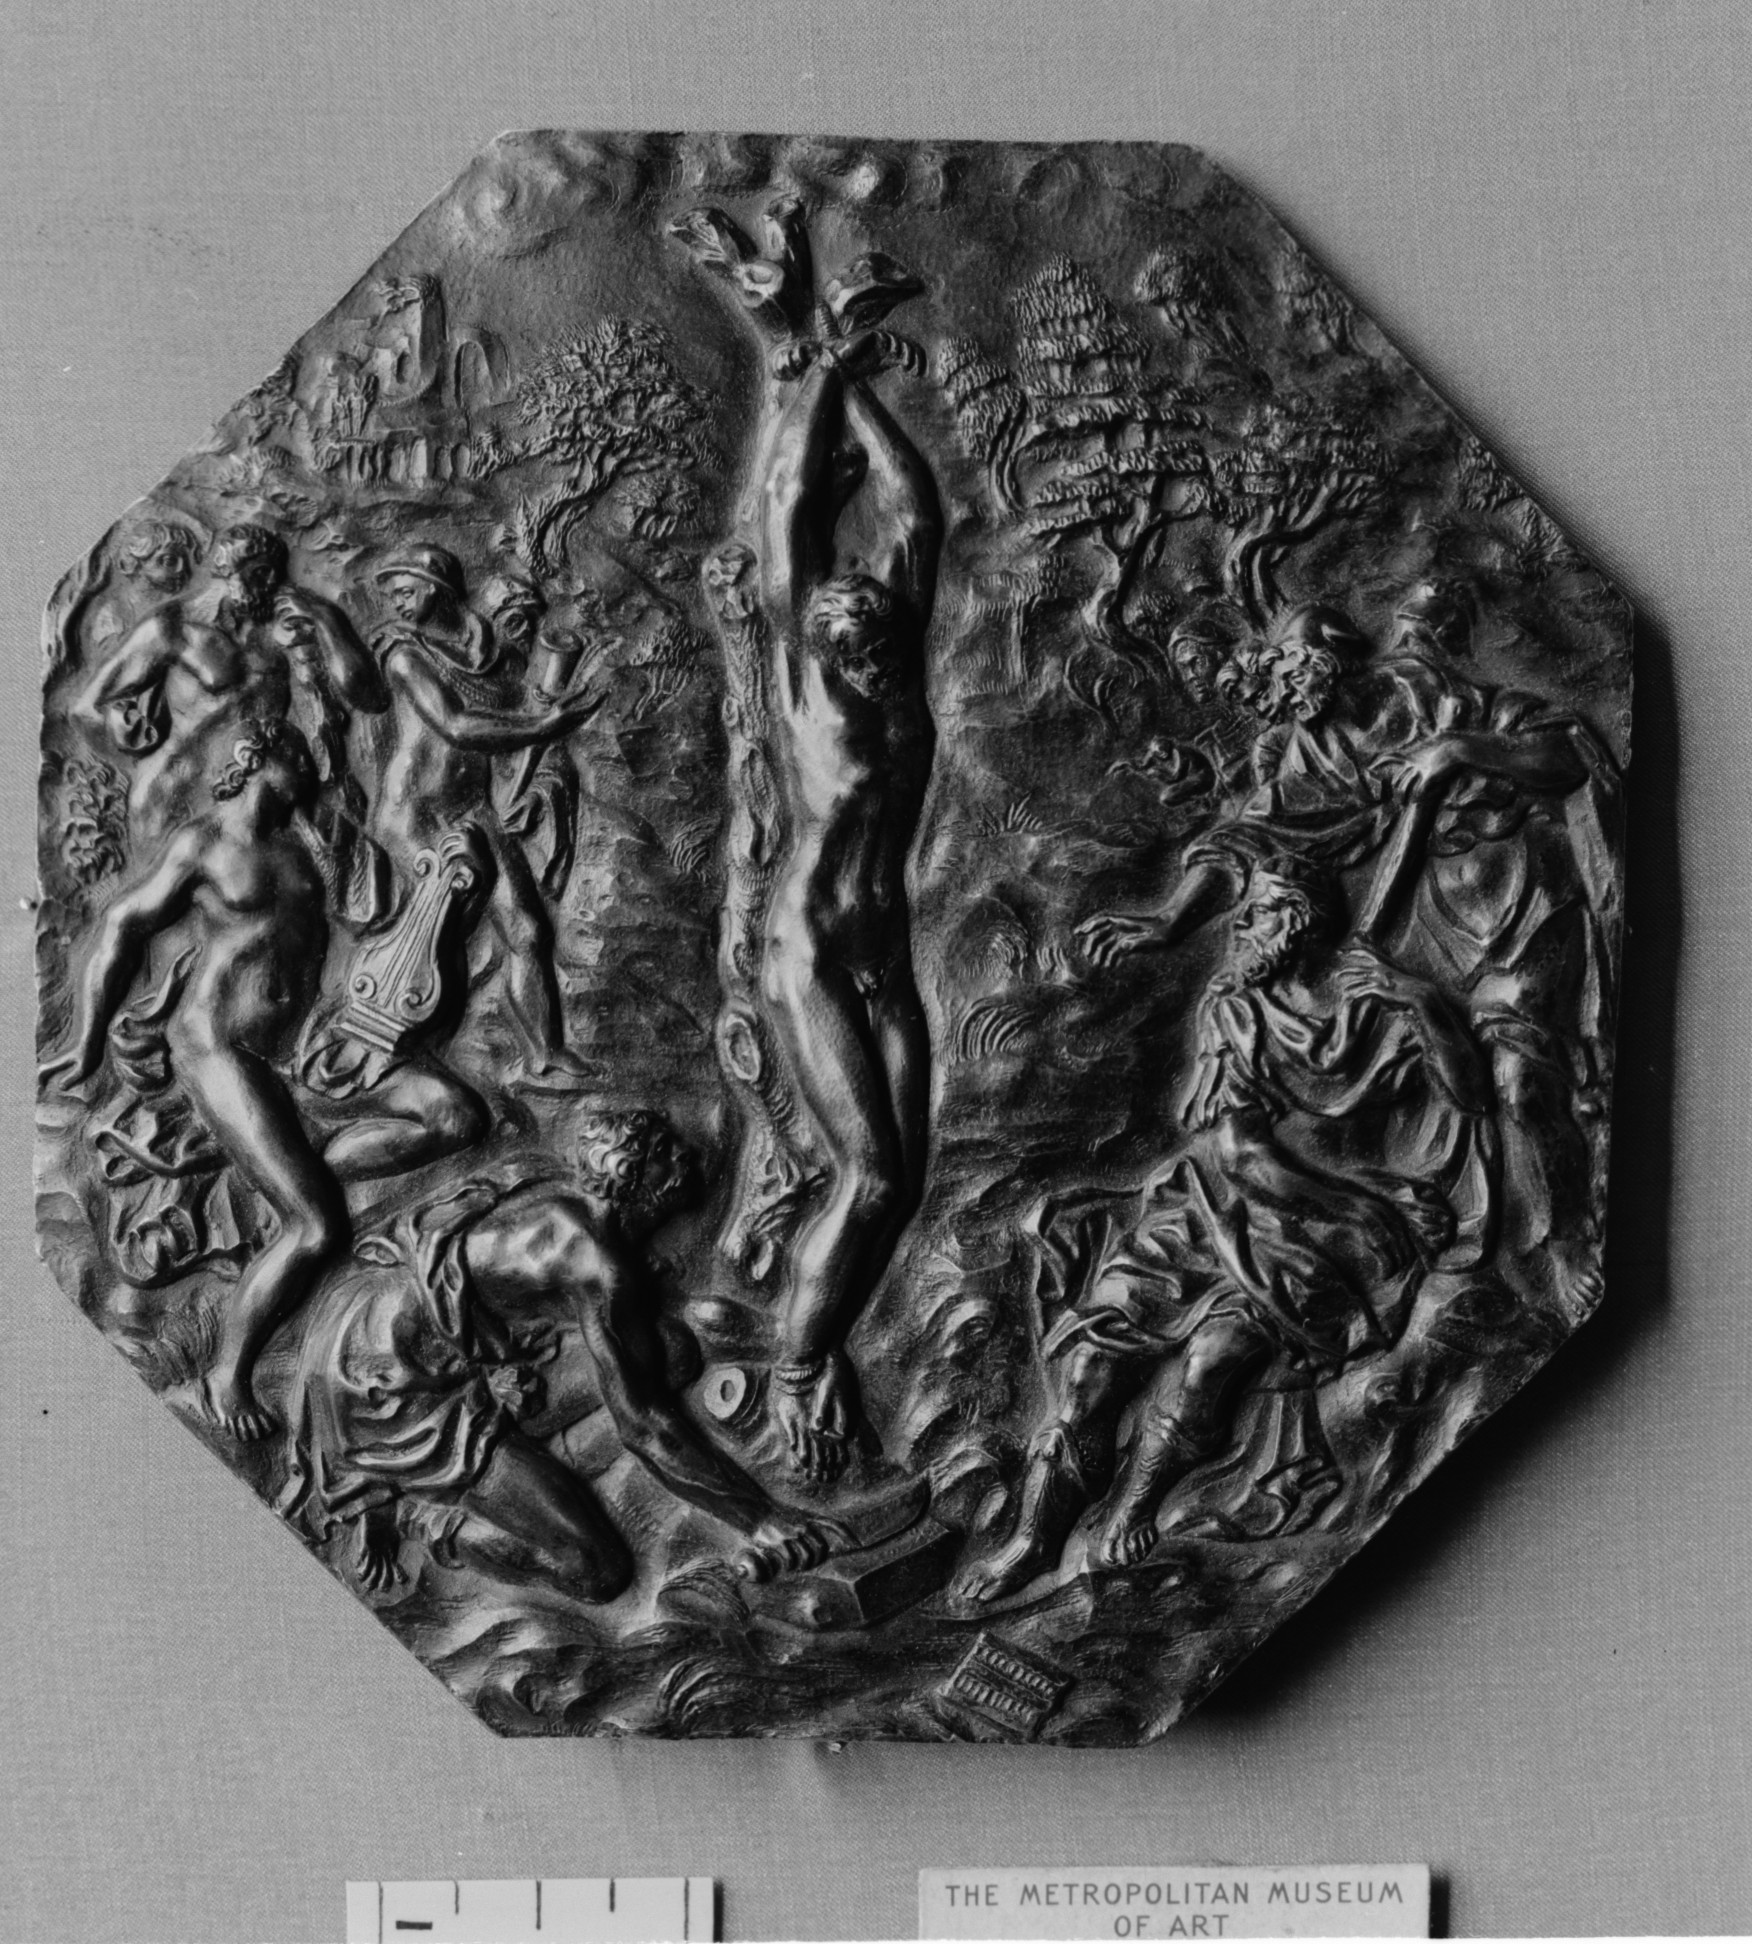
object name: plaquette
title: Flaying of Marsyas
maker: guglielmo della porta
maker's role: artist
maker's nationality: italian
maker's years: 1500-1577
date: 1567-1633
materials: bronze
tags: men,male nudes